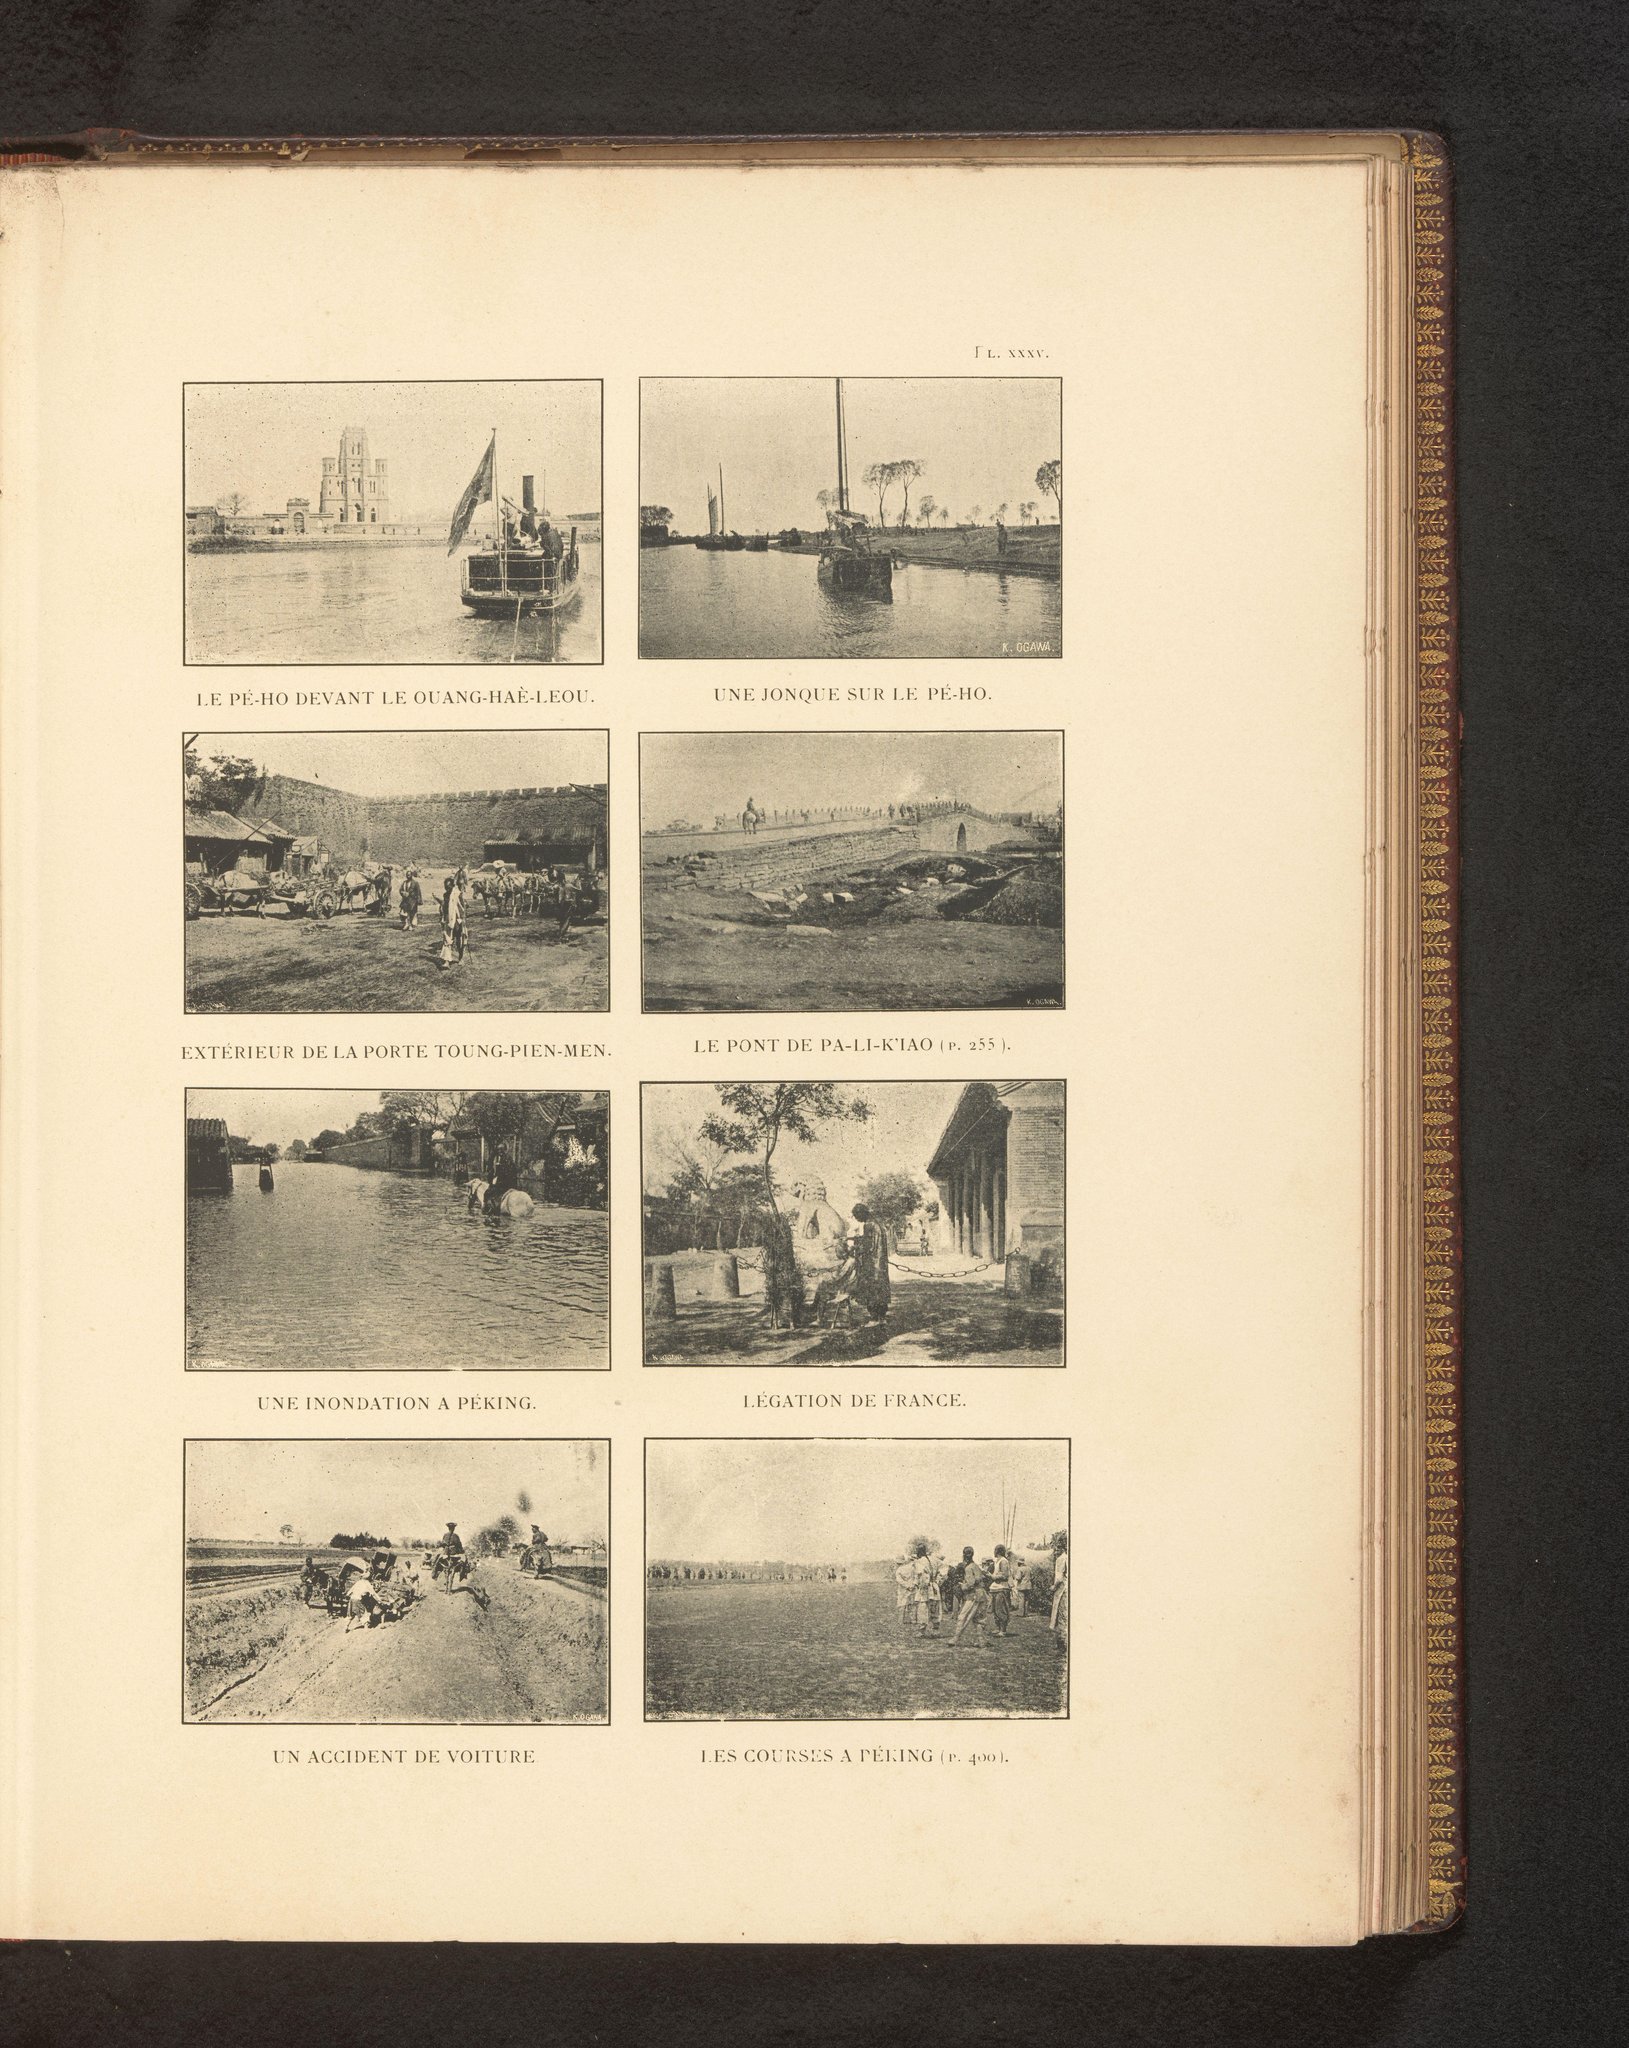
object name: photomechanical print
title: Twee gezichten op een boot te water, Paard en wagen voor een stadsmuur, Gezicht op een brug, Onbekende man te paard in het water na een overstroming, Twee onbekende mannen voor de Franse legatie, Een ongeluk met een paardenkar en Gezicht op toeschouwers bij een race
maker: Anonymous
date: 1892-1897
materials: paper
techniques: autotype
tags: suspension bridge, landscapes with waters, waterscapes, seascapes (in the temperate zone), accident with animal-drawn vehicle, china